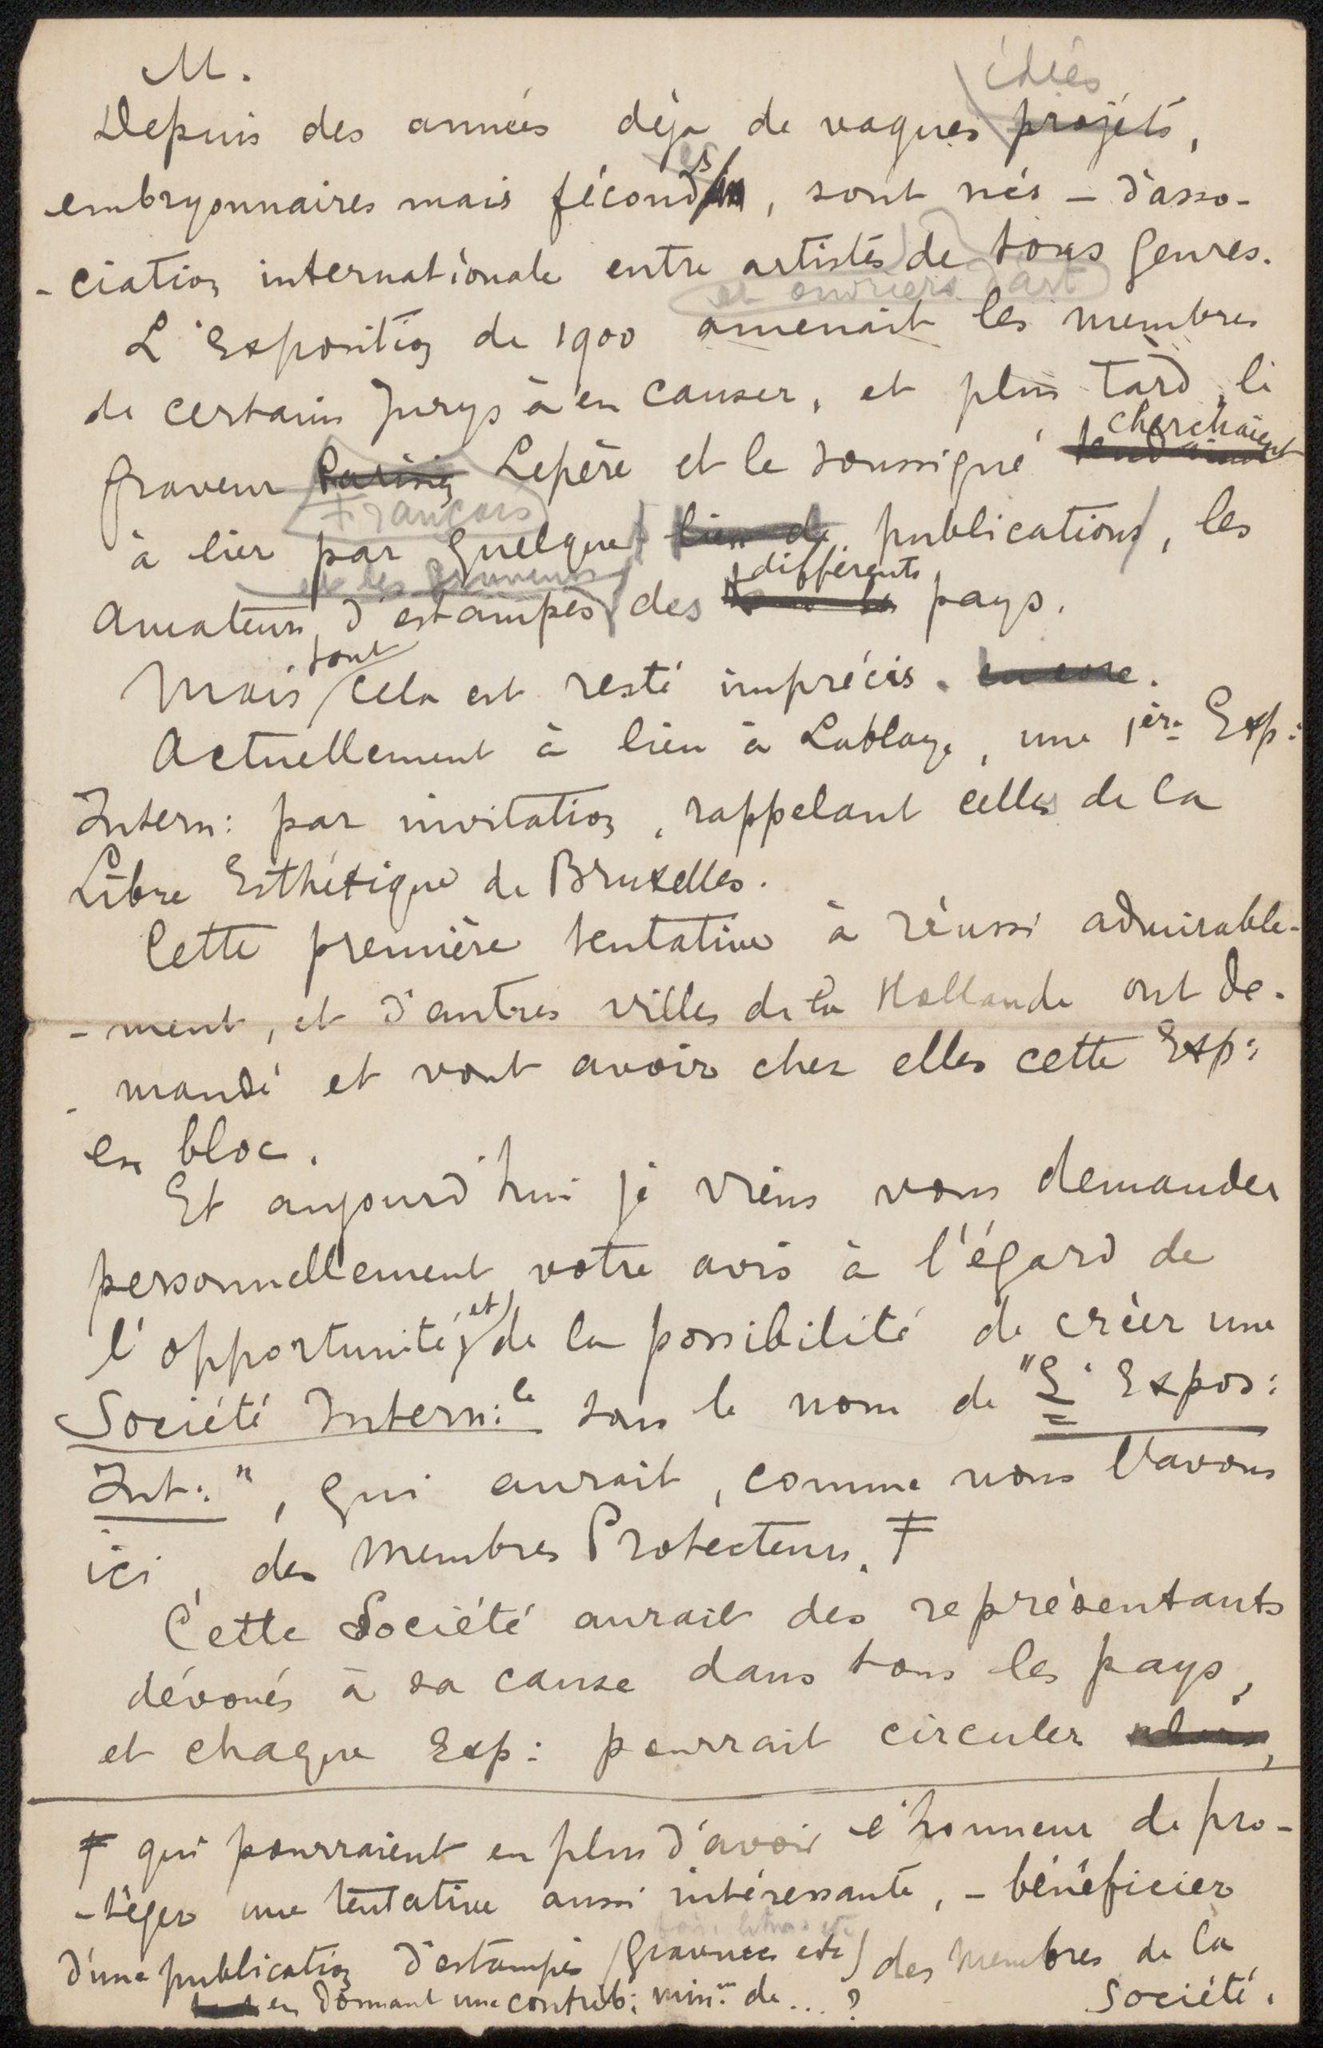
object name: letter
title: Brief aan anoniem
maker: philip zilcken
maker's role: draughtsman, painter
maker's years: 1857-1930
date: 1901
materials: ink, paper, pencil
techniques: pen, writing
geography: the hague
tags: auguste lepère, the graphic arts, exhibition ~ art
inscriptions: collector's mark: ‘RPK’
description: Brief is bewaard bij correspondentie van Auguste Lepère aan Philip Zilcken.